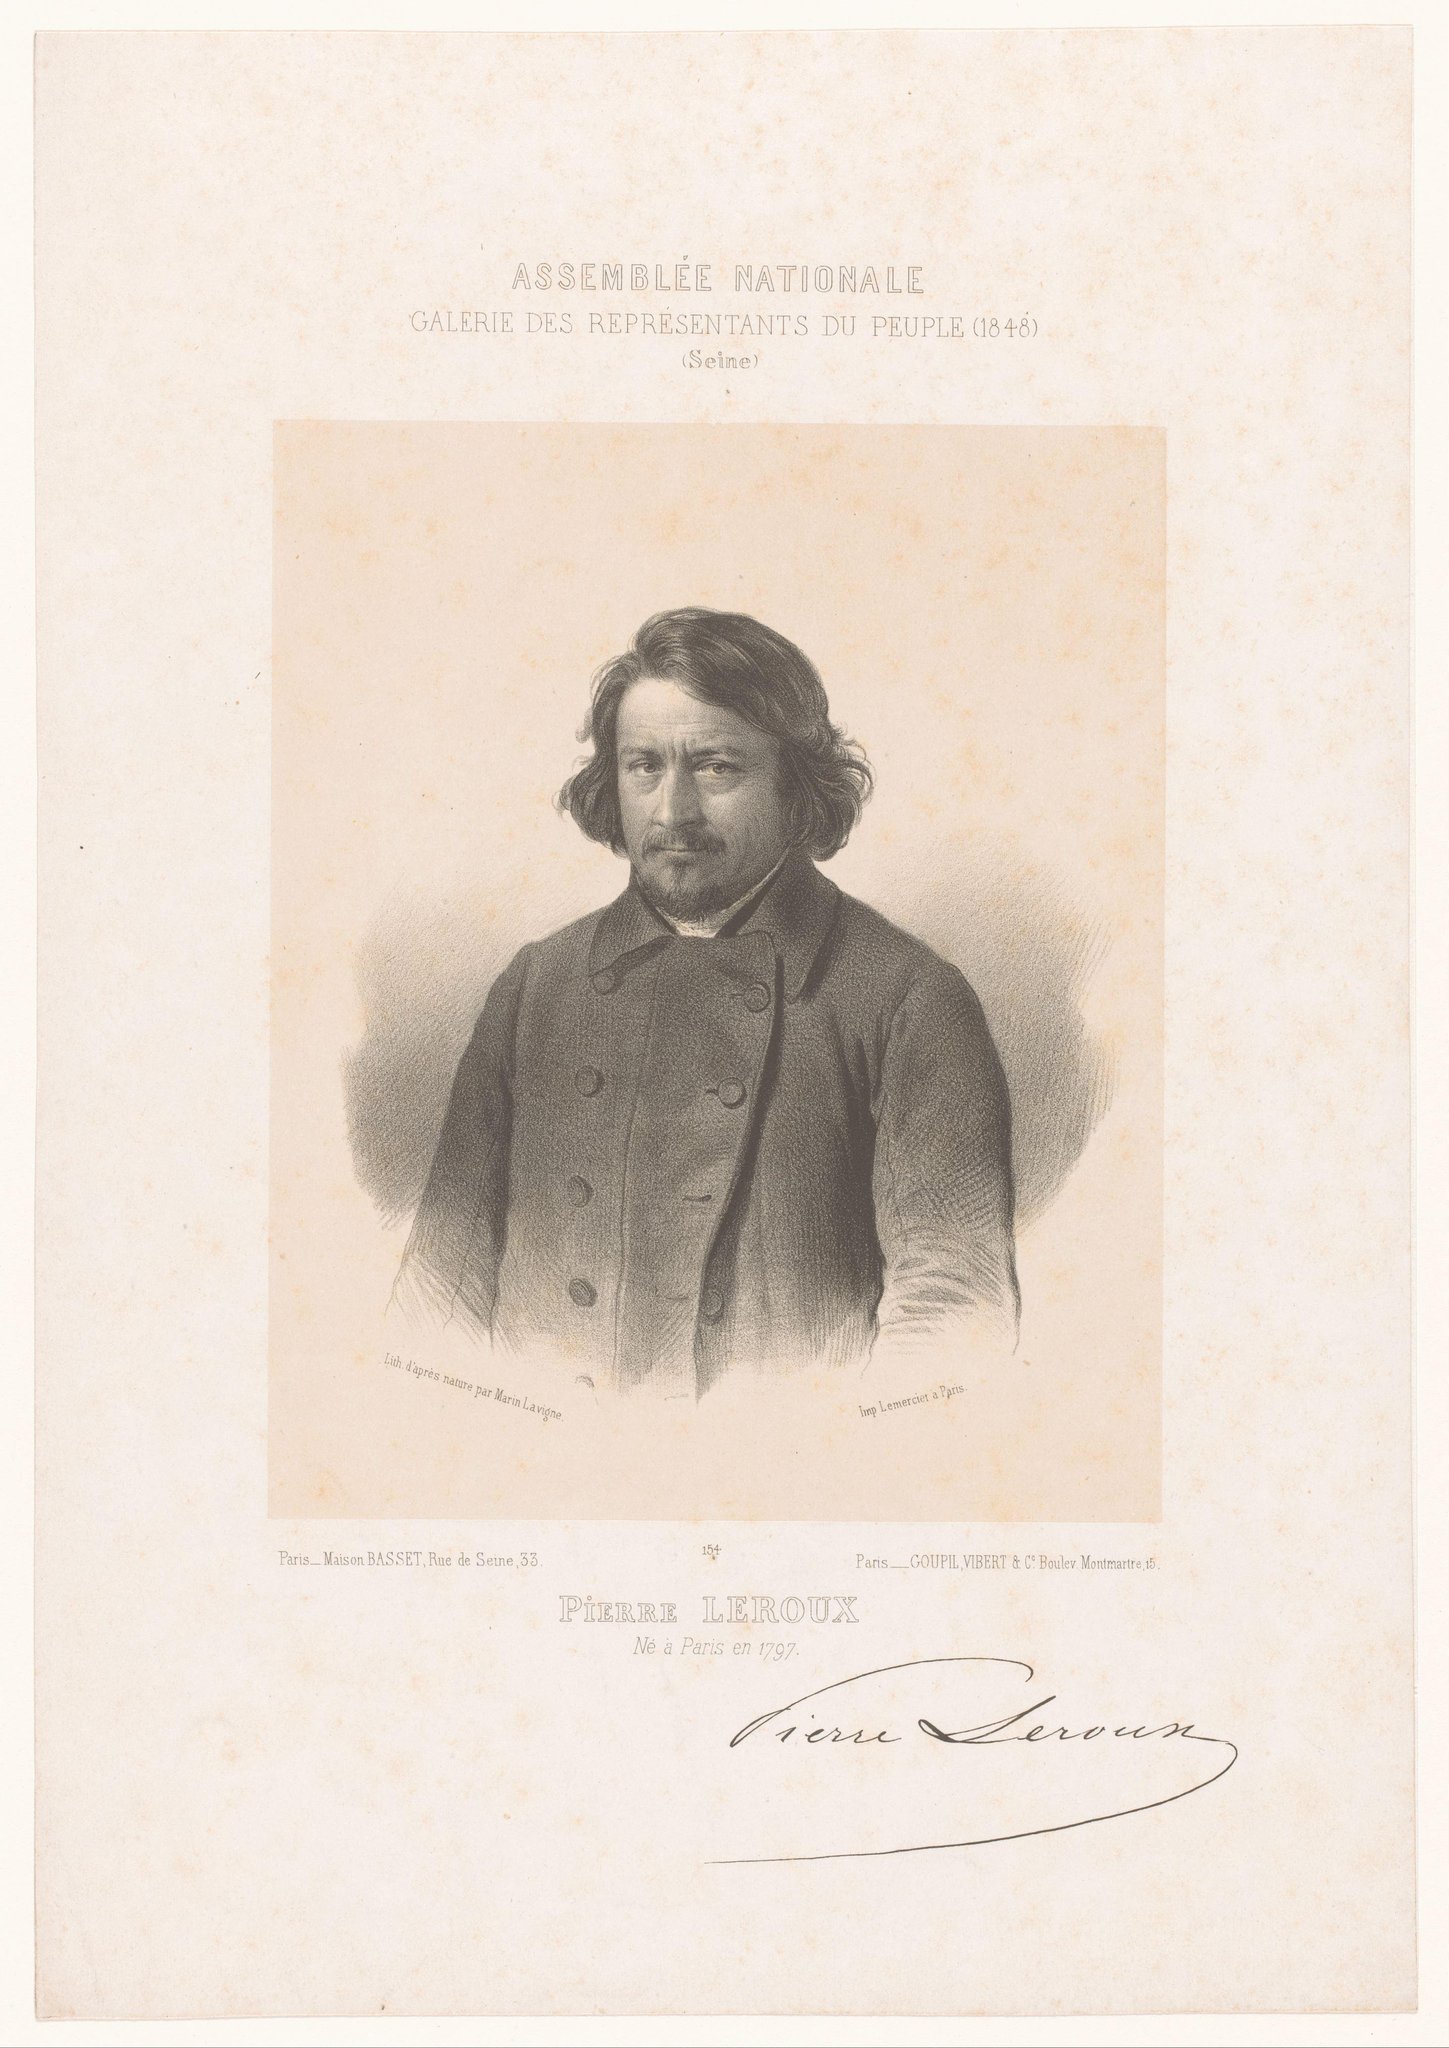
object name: print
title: Assemblée Nationale. Galerie des représentants du peuple (1848)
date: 1848-1849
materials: paper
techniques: tone lithography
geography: paris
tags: paris, politician, publisher, historical persons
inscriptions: collector's mark: Lugt 2228